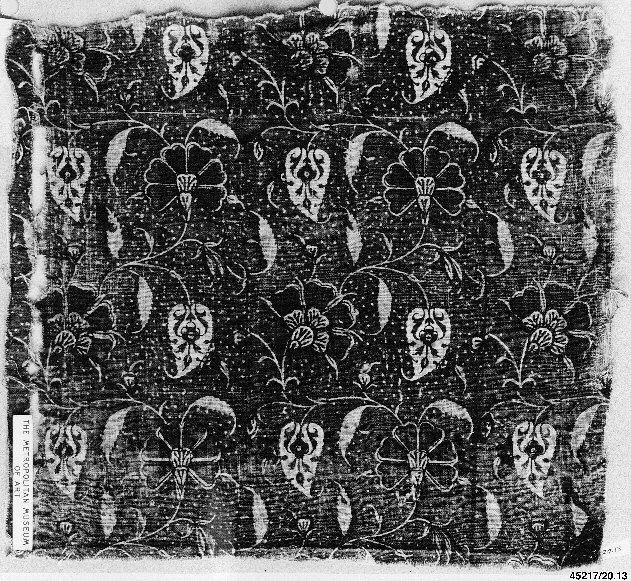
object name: textile fragment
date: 1701-1800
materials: cotton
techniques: printing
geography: india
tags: flowers,leaves